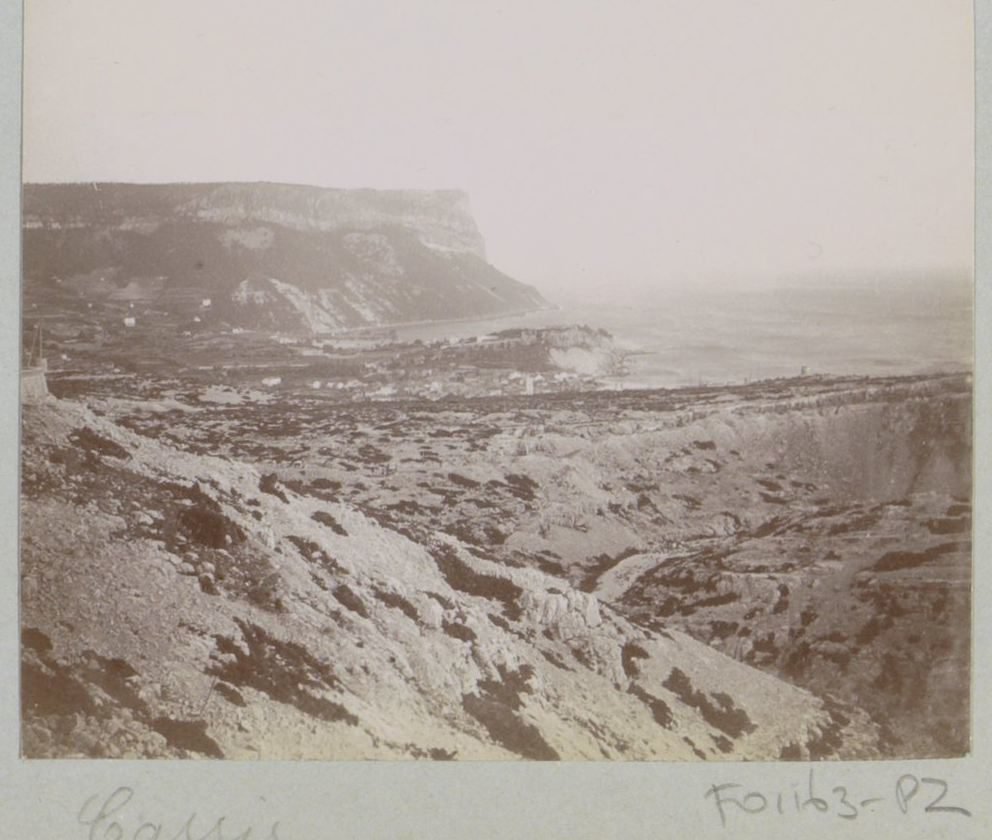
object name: photograph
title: Landschap bij Cassis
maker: delizy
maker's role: manufacturer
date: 1903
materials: paper, photographic support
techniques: gelatin silver print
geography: cassis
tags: harbour (+ view ~ vehicle, ship, etc.)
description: Onderdeel van Fotoalbum van een Franse amateurfotograaf met opnames van uitstapjes in Frankrijk, Spanje, België, Luxemburg en Nederland, de eerste automobielen en autoraces.